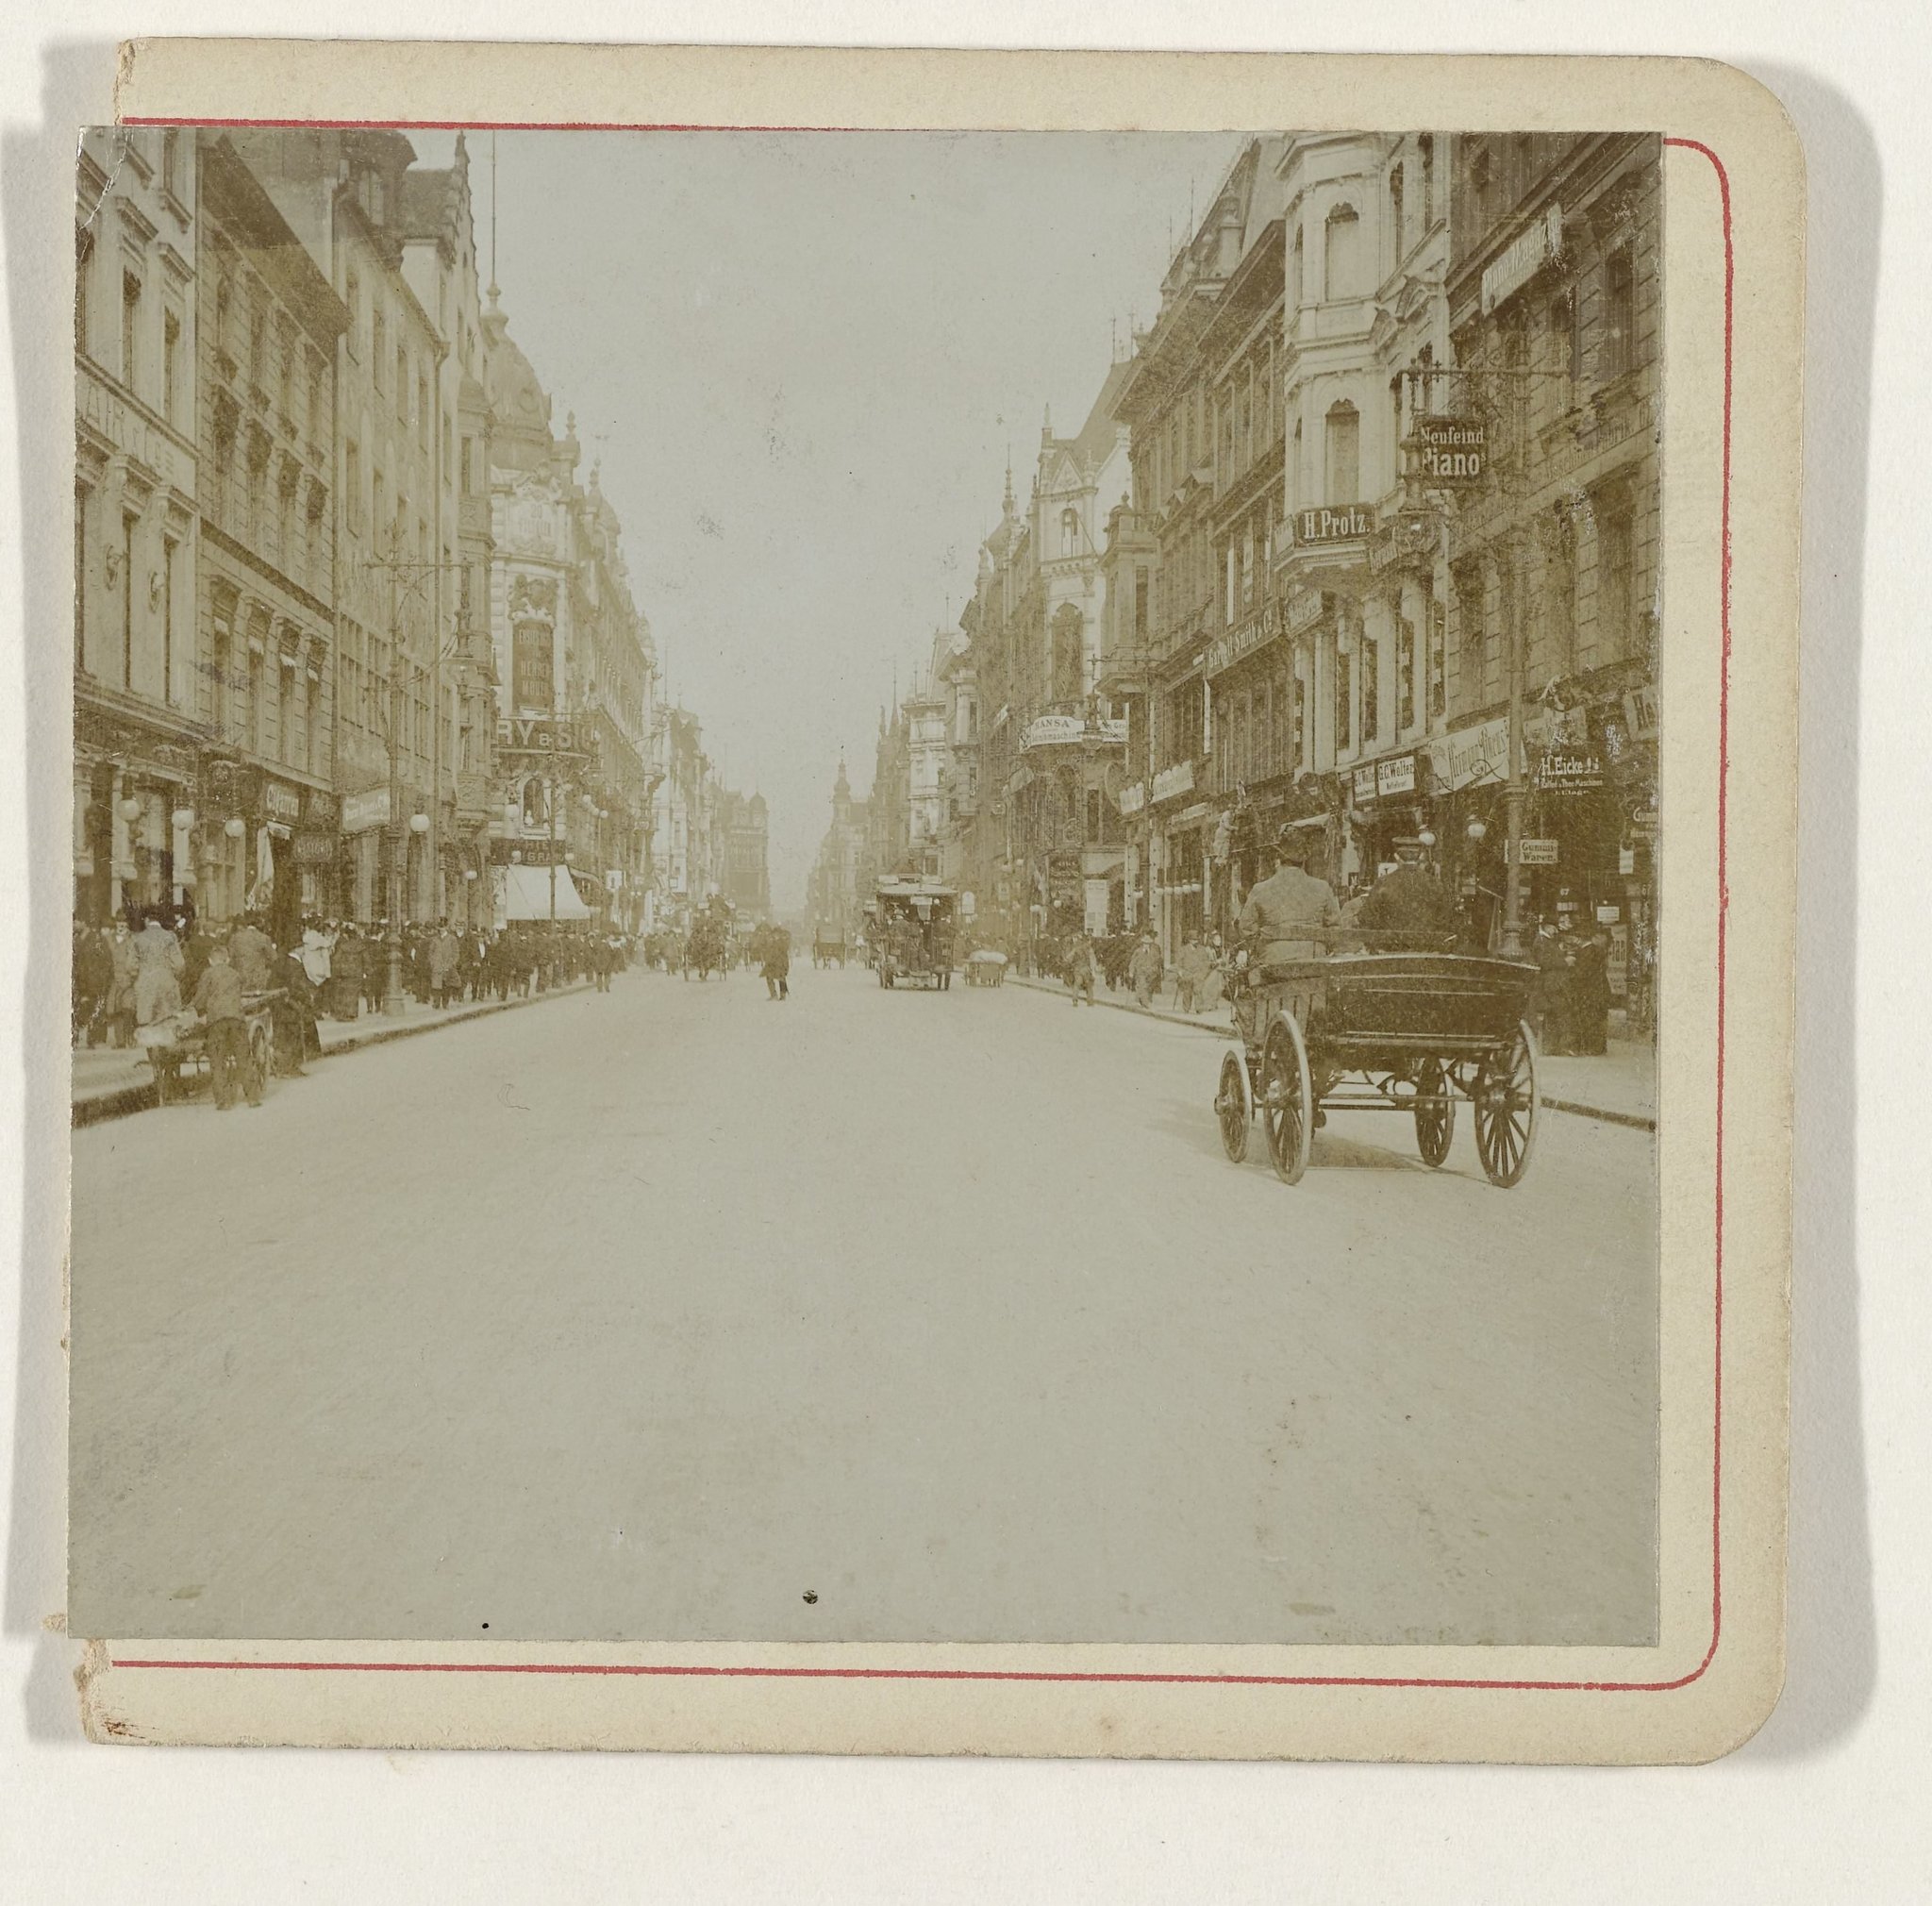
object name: stereograph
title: De Friedrichstrasse, Berlijn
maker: geldolph adriaan kessler (dolph)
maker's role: fotograaf, industrieel, voetballer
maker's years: 1884-1945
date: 1903-1910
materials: cardboard, paper, photographic support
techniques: collodion silver print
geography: berlin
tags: berlin